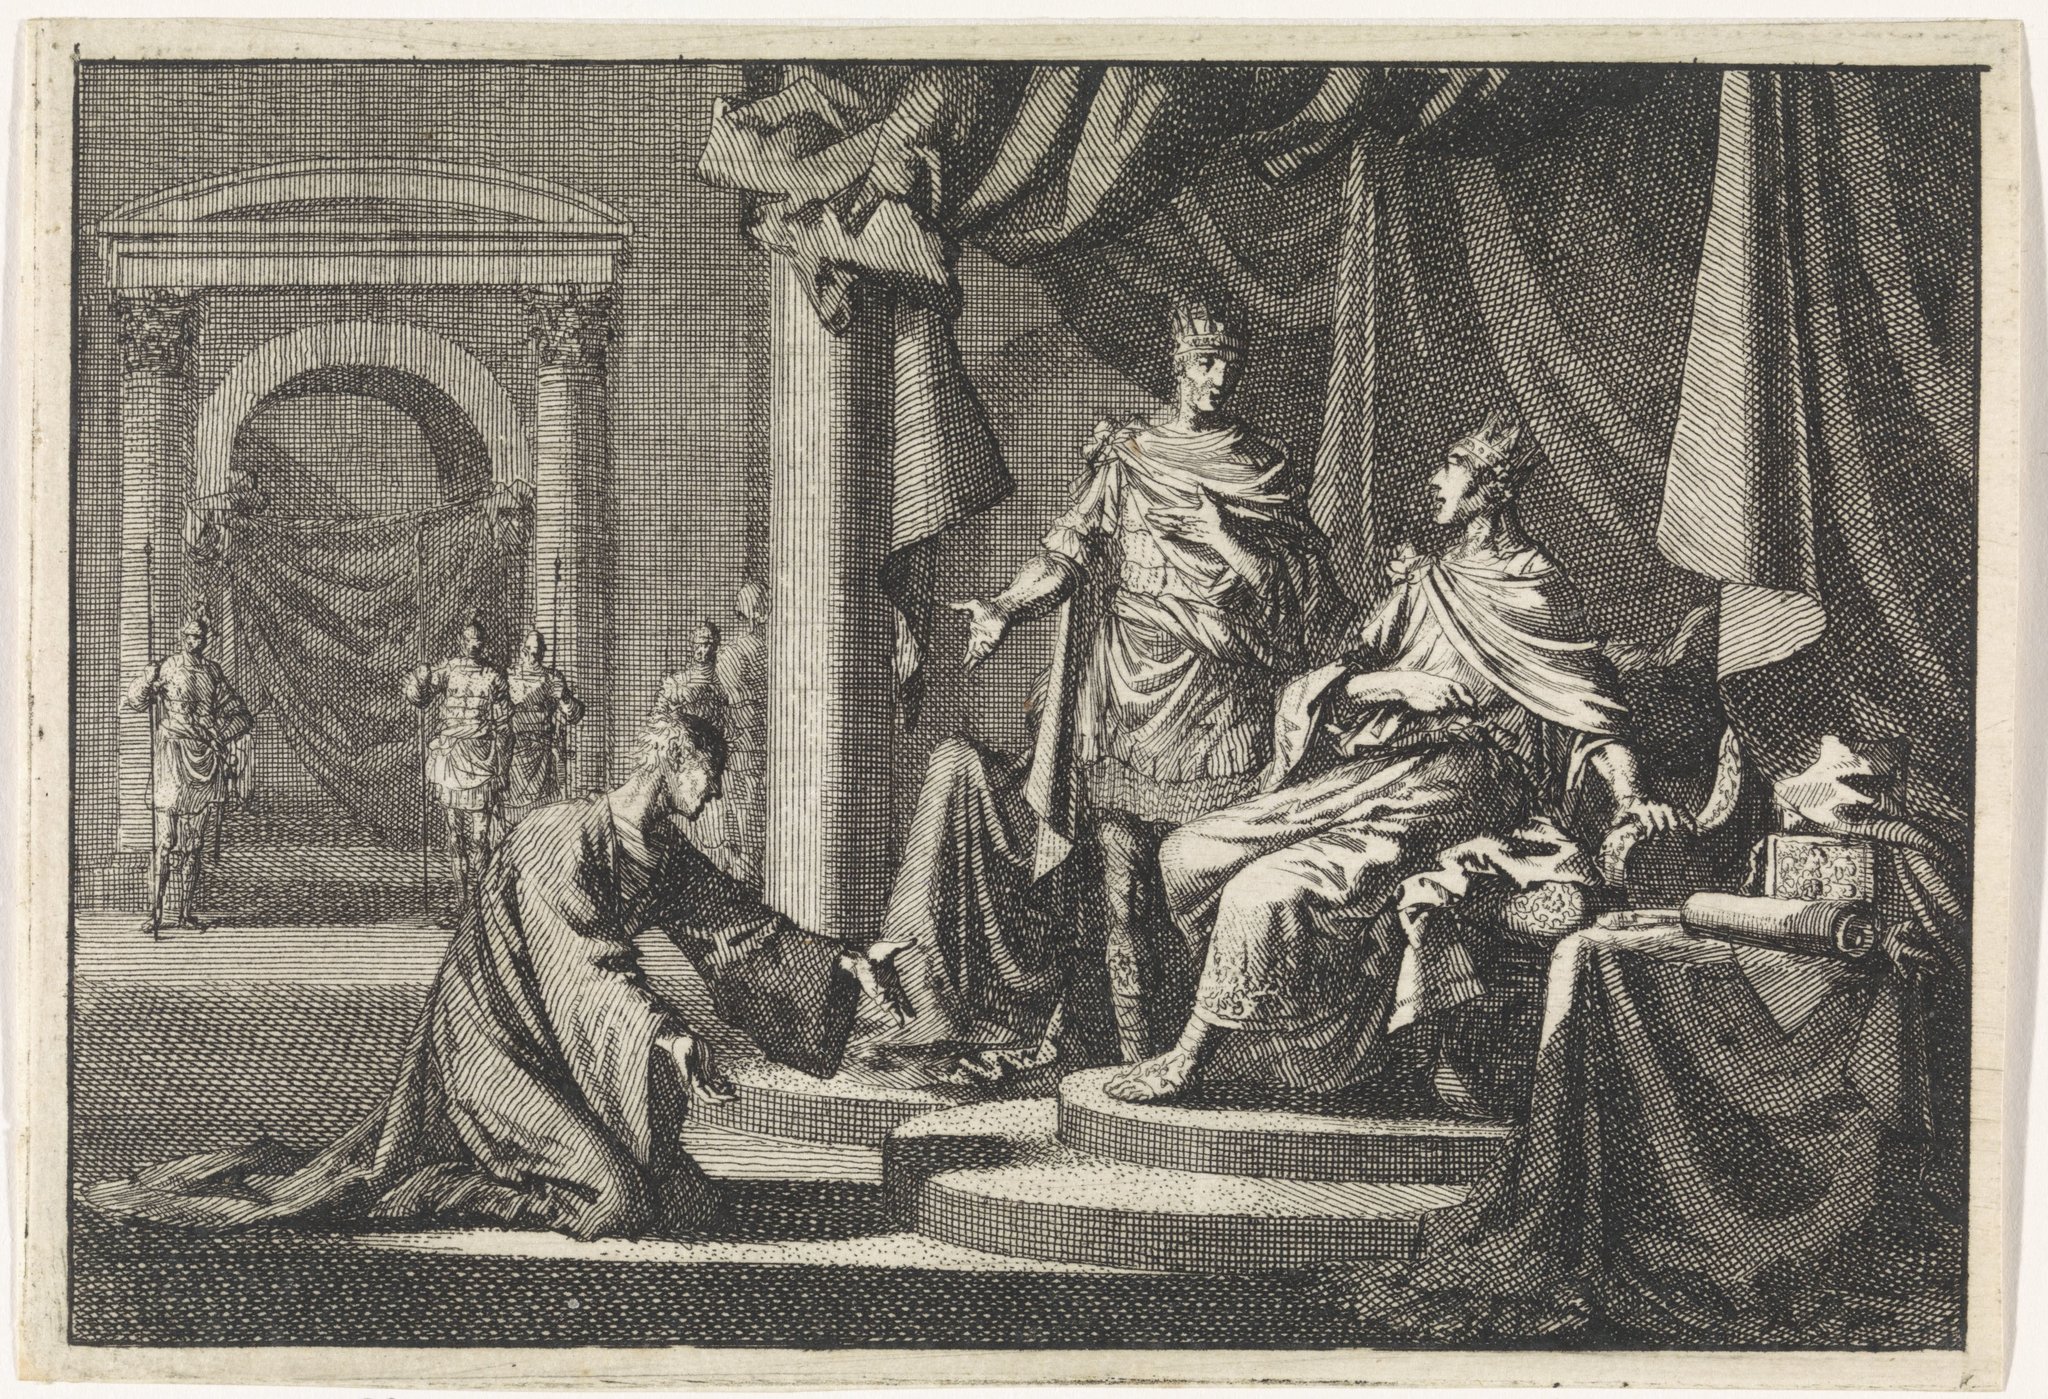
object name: print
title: Pheroras knielt in boetekleed voor zijn broer Herodes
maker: jan luyken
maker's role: draughtsman, print maker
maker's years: 1649-1712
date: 1704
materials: paper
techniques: etching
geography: amsterdam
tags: kneeling before a ruler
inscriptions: collector's mark: Lugt 2228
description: Prent ook gebruikt als boekillustratie in: Josephus, Flavius. Alle de Werken, 2 delen. Amsterdam: Pieter Mortier, 1704, dl. 2, p. 545.